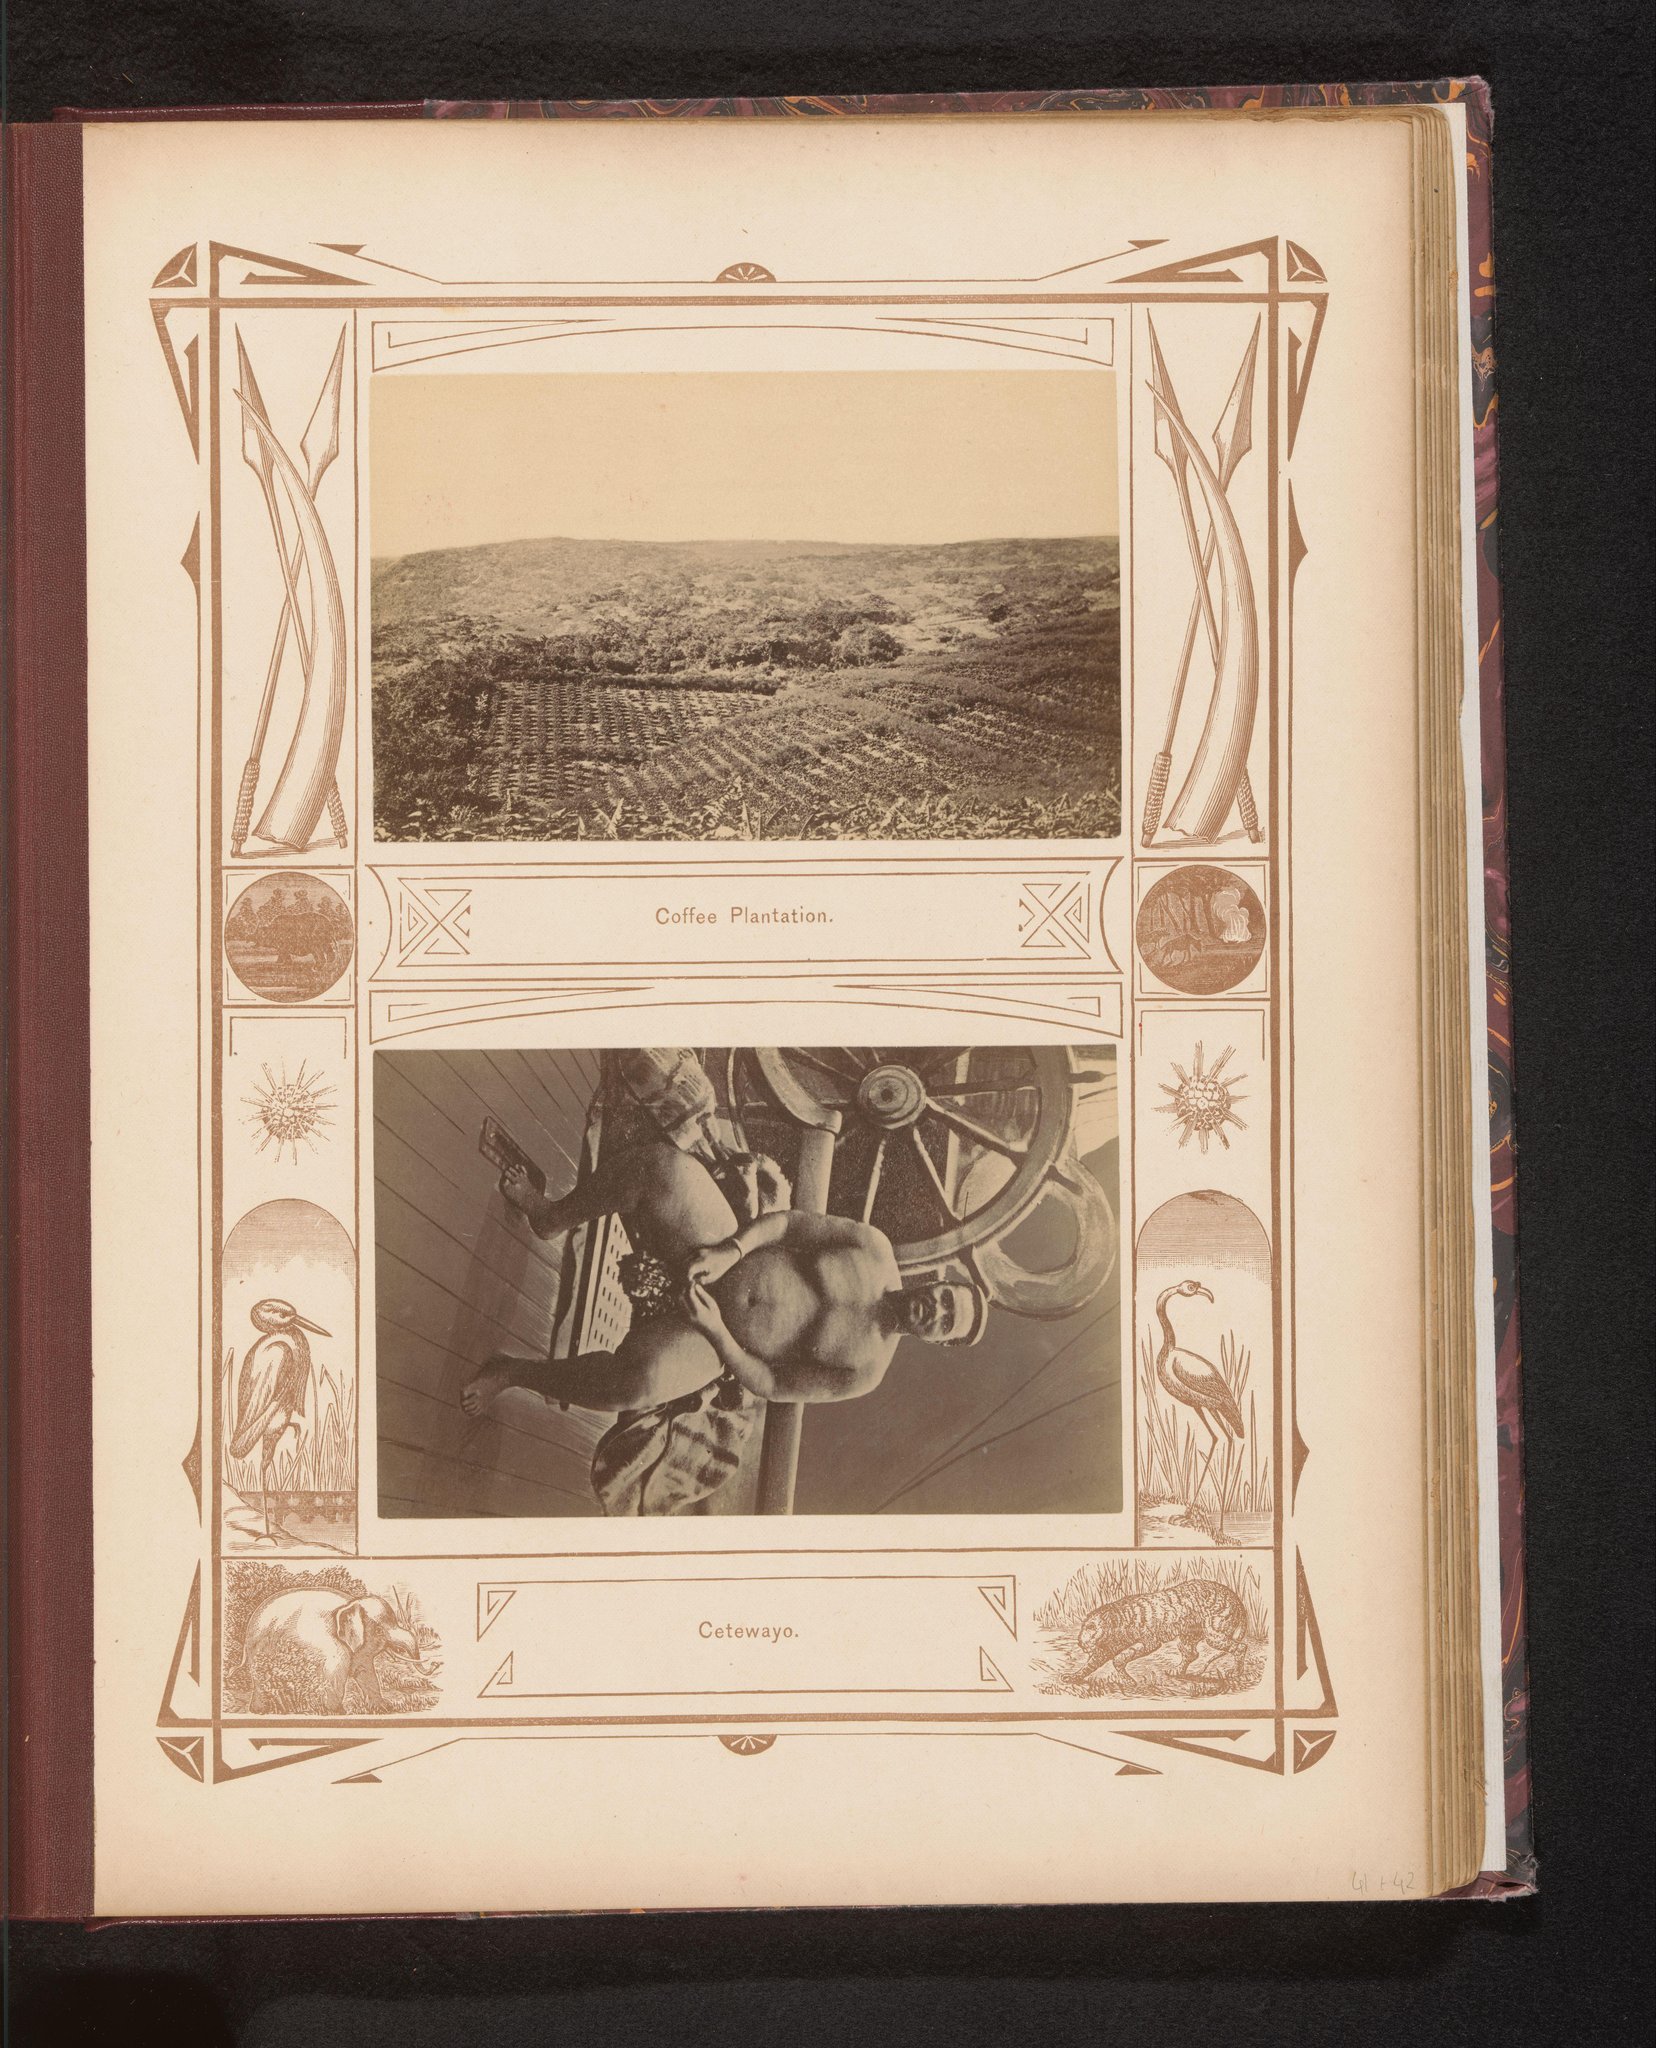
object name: photograph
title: Portret van Cetshwayo kaMpande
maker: Anonymous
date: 1877-1882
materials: photographic support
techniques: albumen print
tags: africans, adult man, historical persons, king